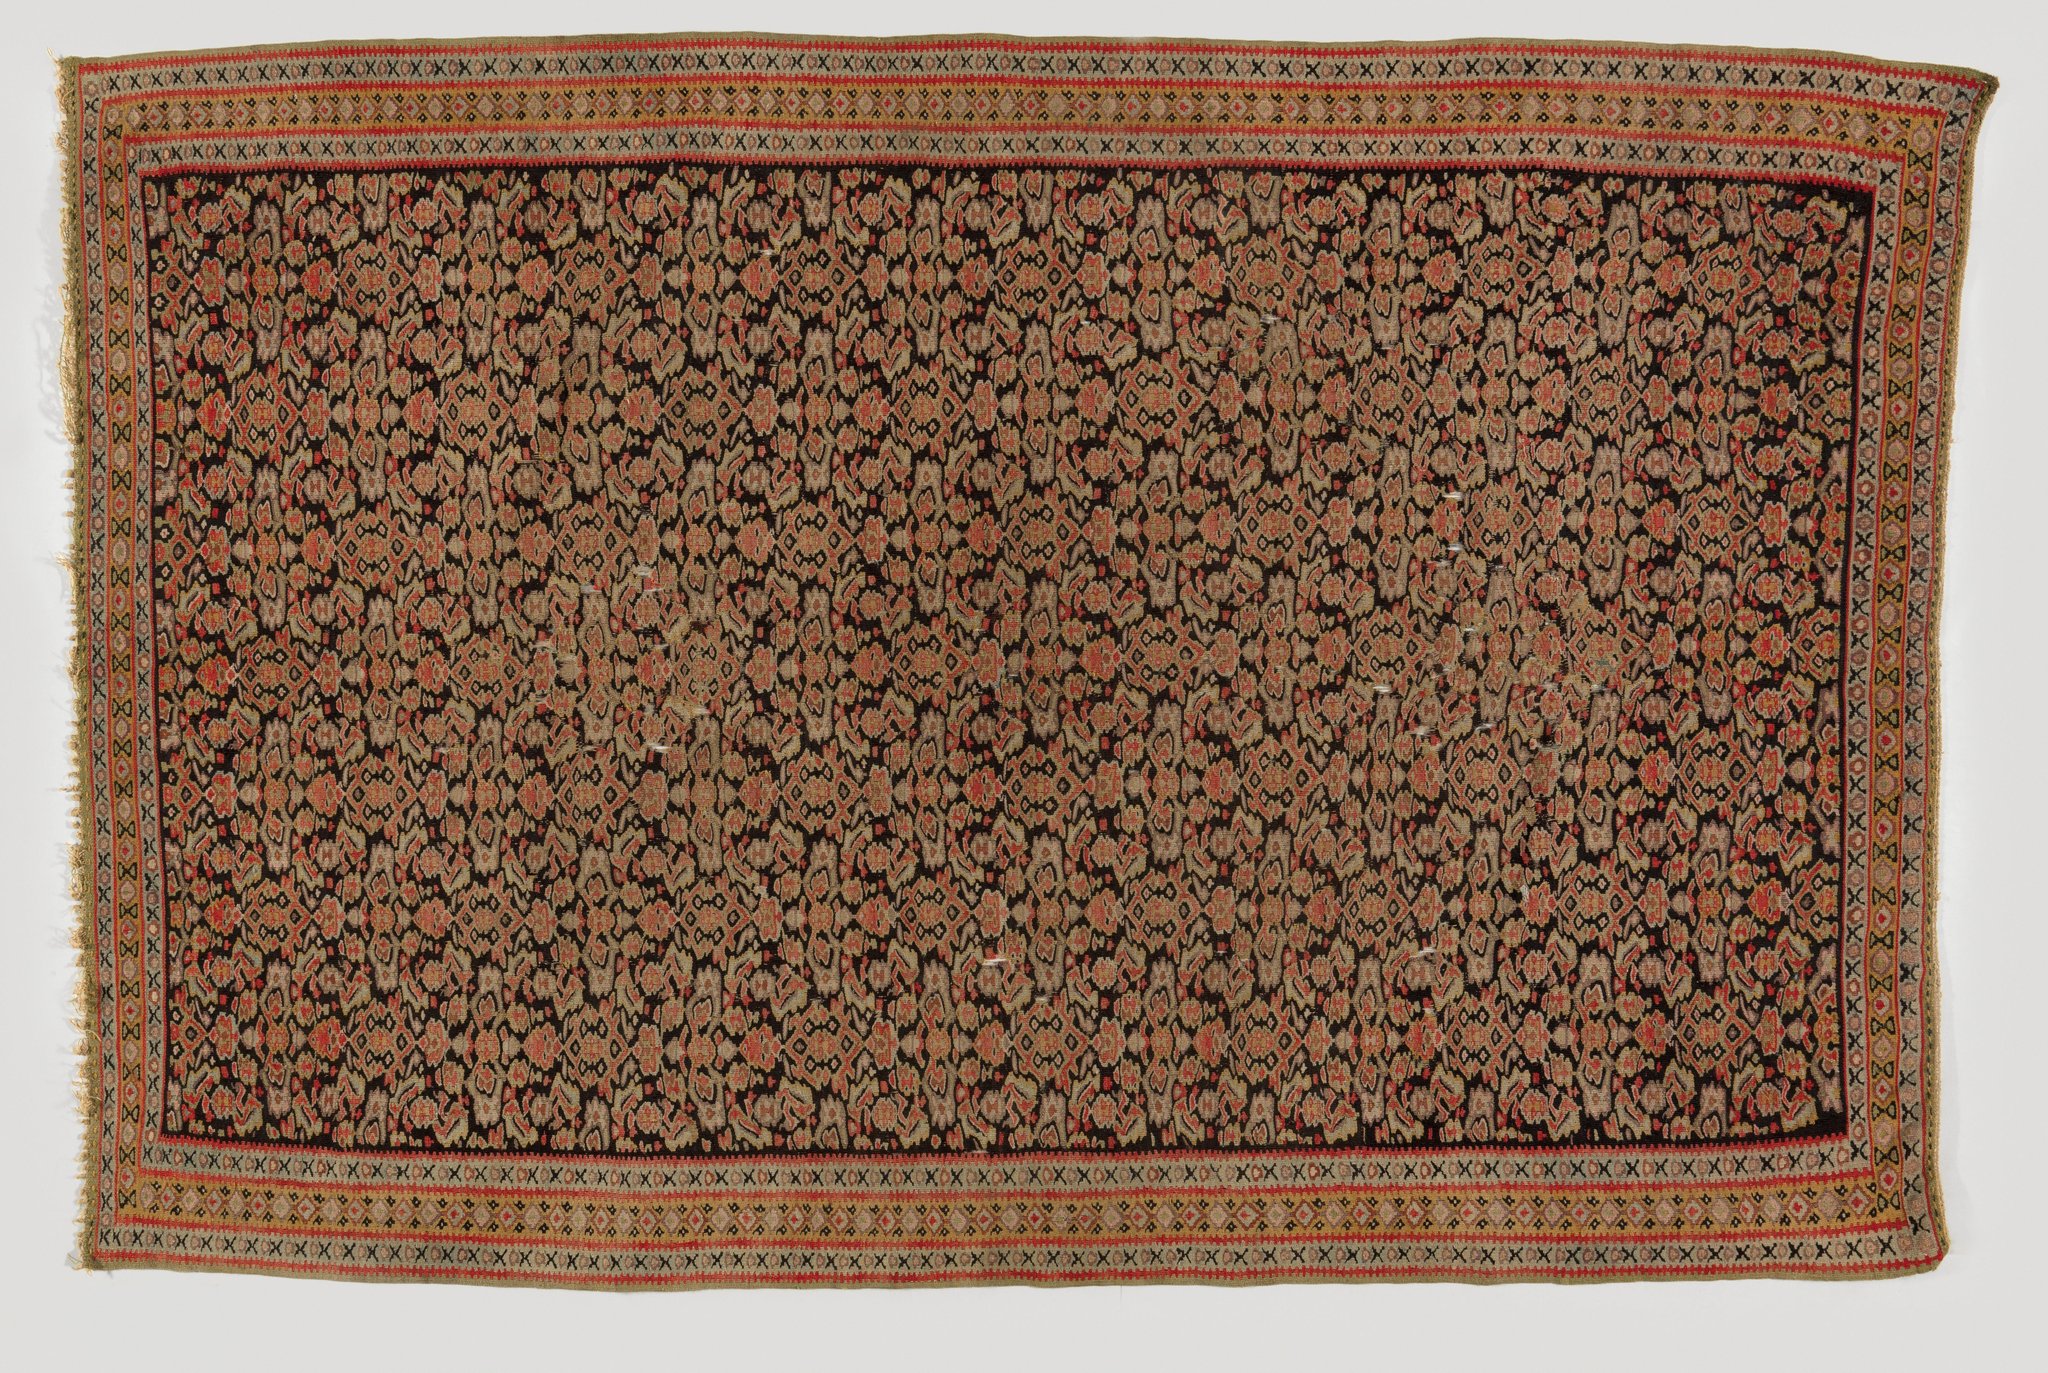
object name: kilim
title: Kelim met Herati-patroon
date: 1900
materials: wool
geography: iran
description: Kelimkleed dat op een zwart fond een fijn Herati-patroon vertoont en drie smalle randen in blauw, geel en blauw.